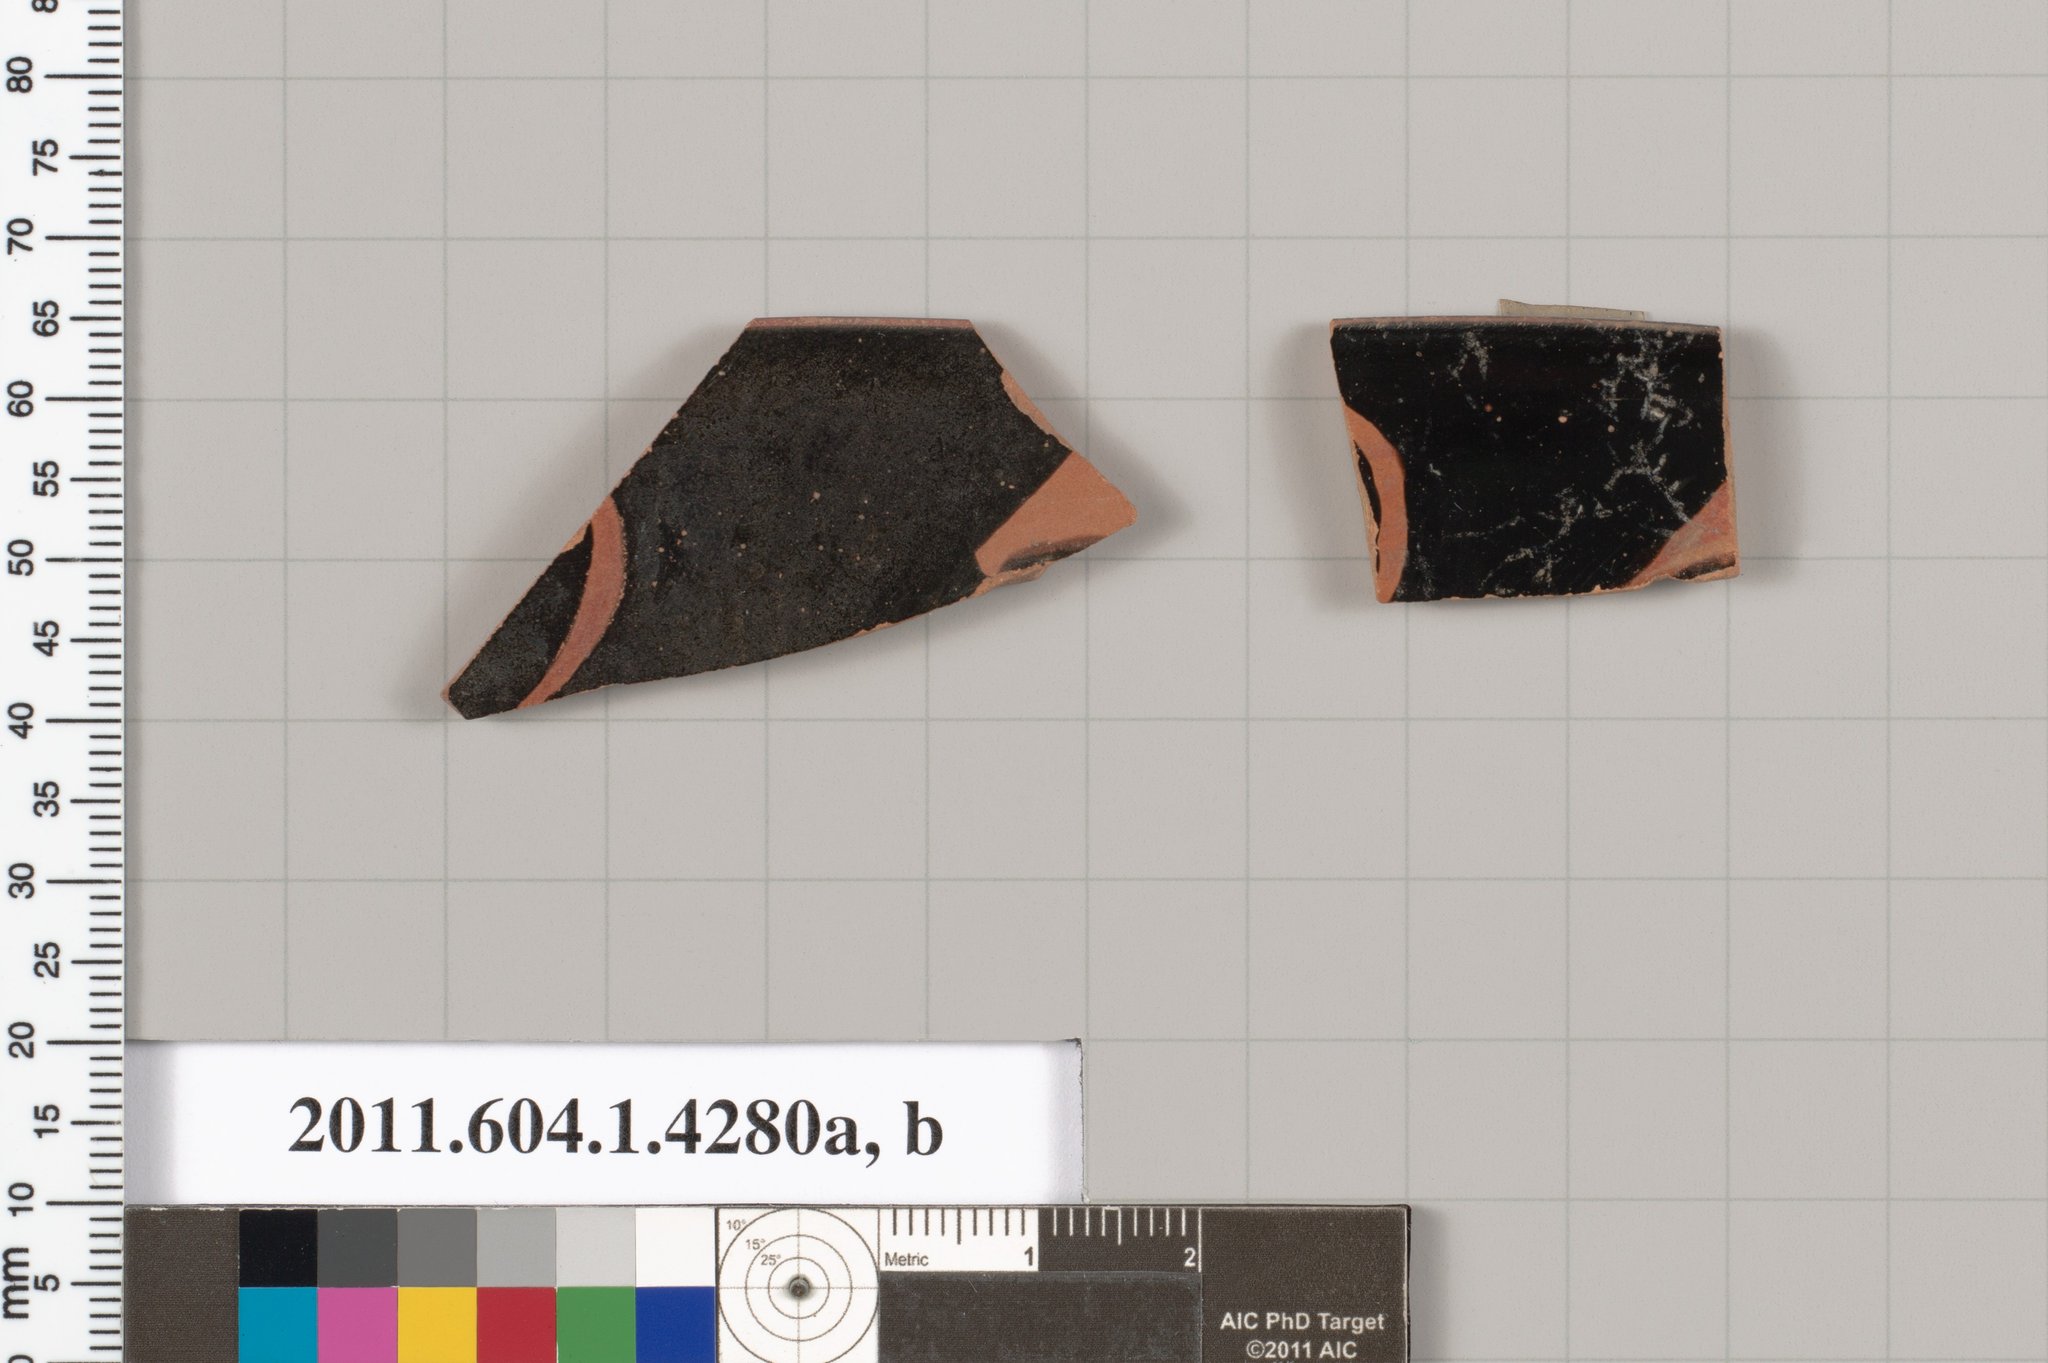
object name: kylix fragment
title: Terracotta rim fragments of kylikes (drinking cups)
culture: greek, attic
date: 500-451 BCE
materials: terracotta